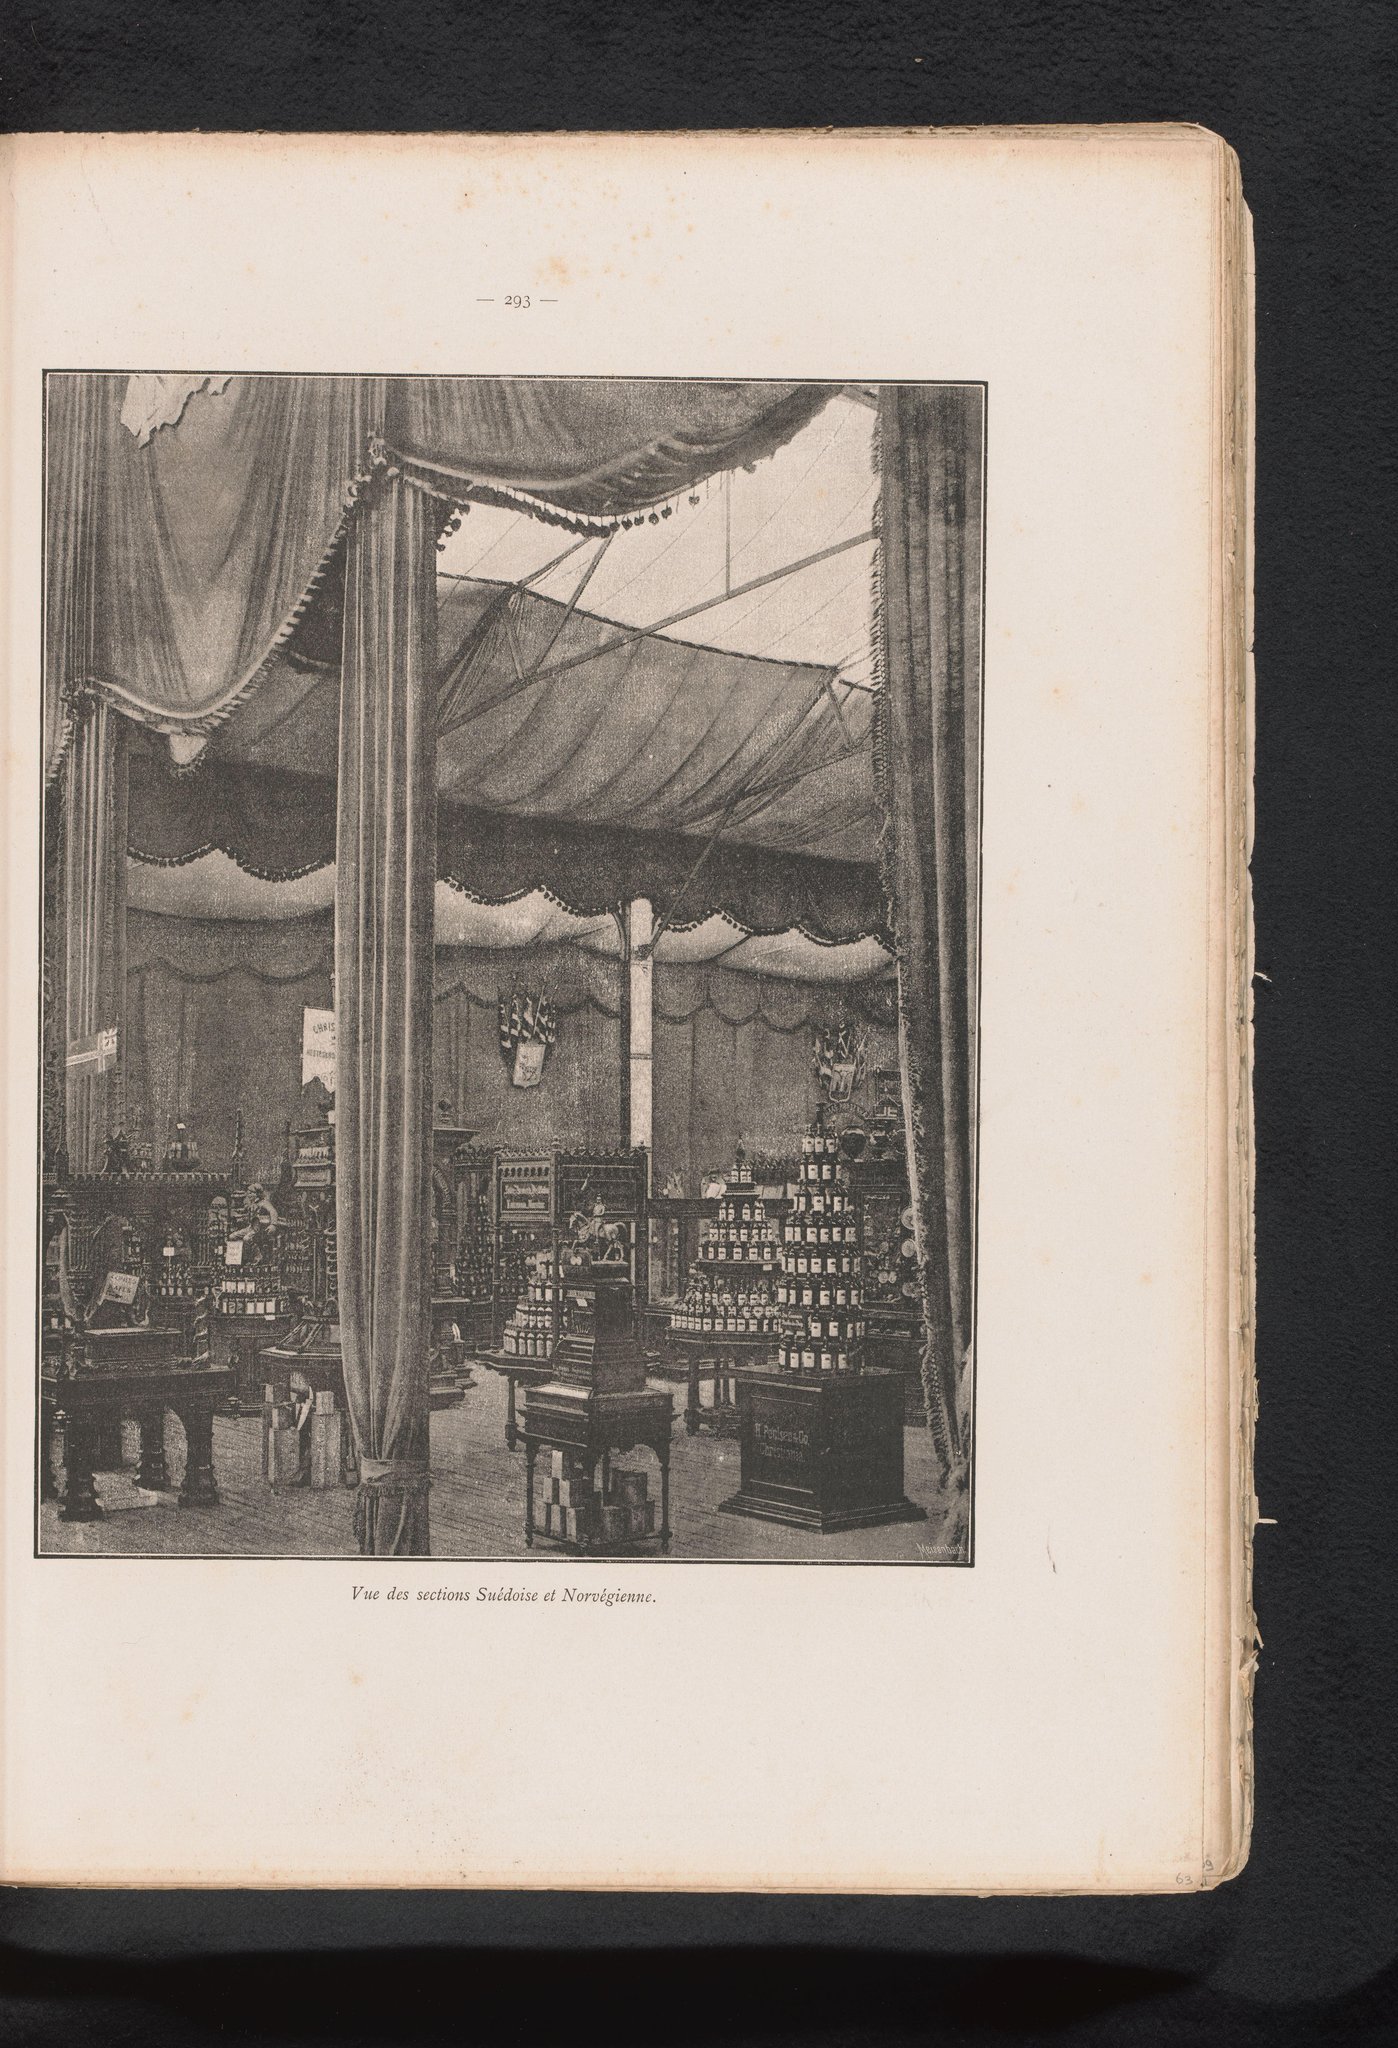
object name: page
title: Vue des sections Suédoise et Norvégienne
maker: Anonymous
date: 1880-1885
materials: paper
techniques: autotype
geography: antwerp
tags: world fair, world exhibition, antwerp